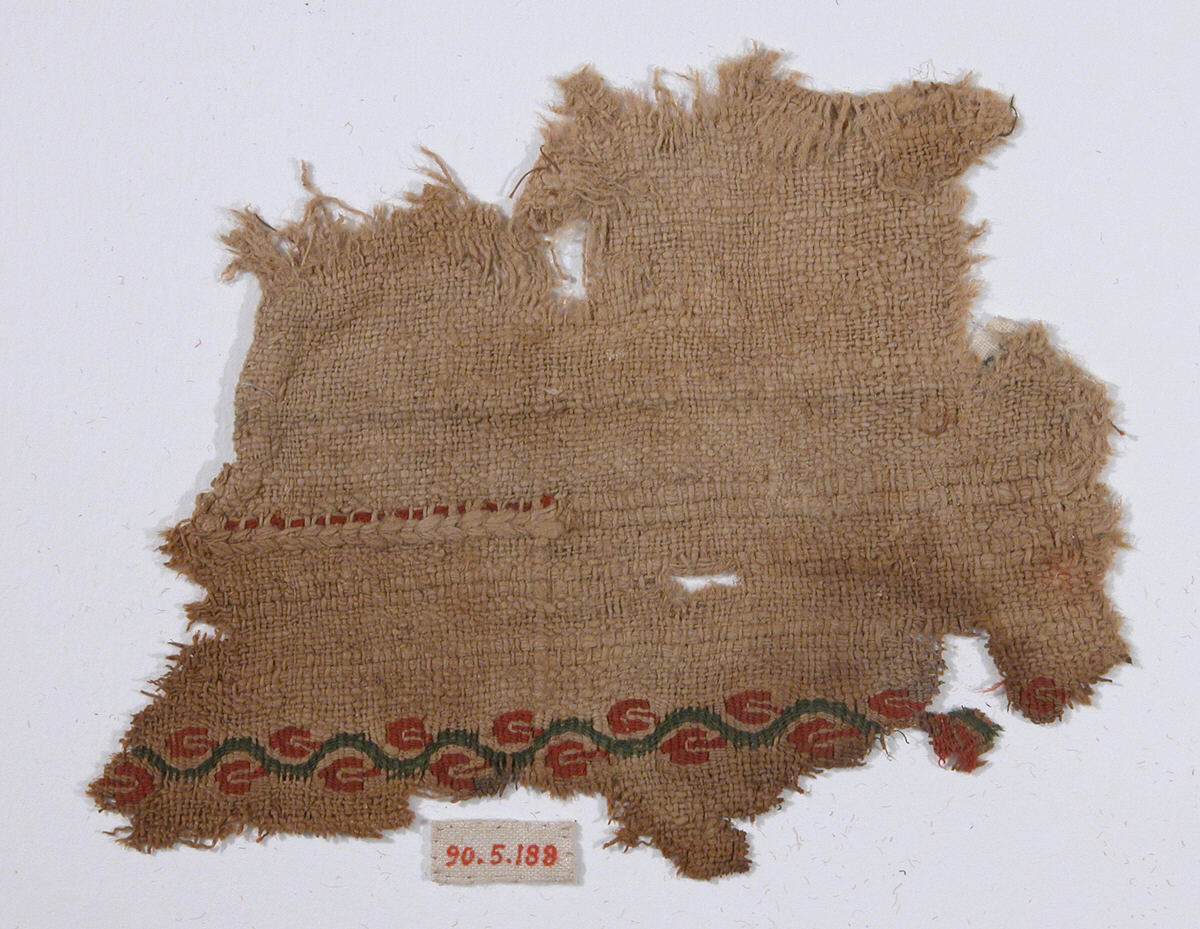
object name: textile fragment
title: Fragment of a Tunic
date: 401-500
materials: linen, wool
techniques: weave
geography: egypt